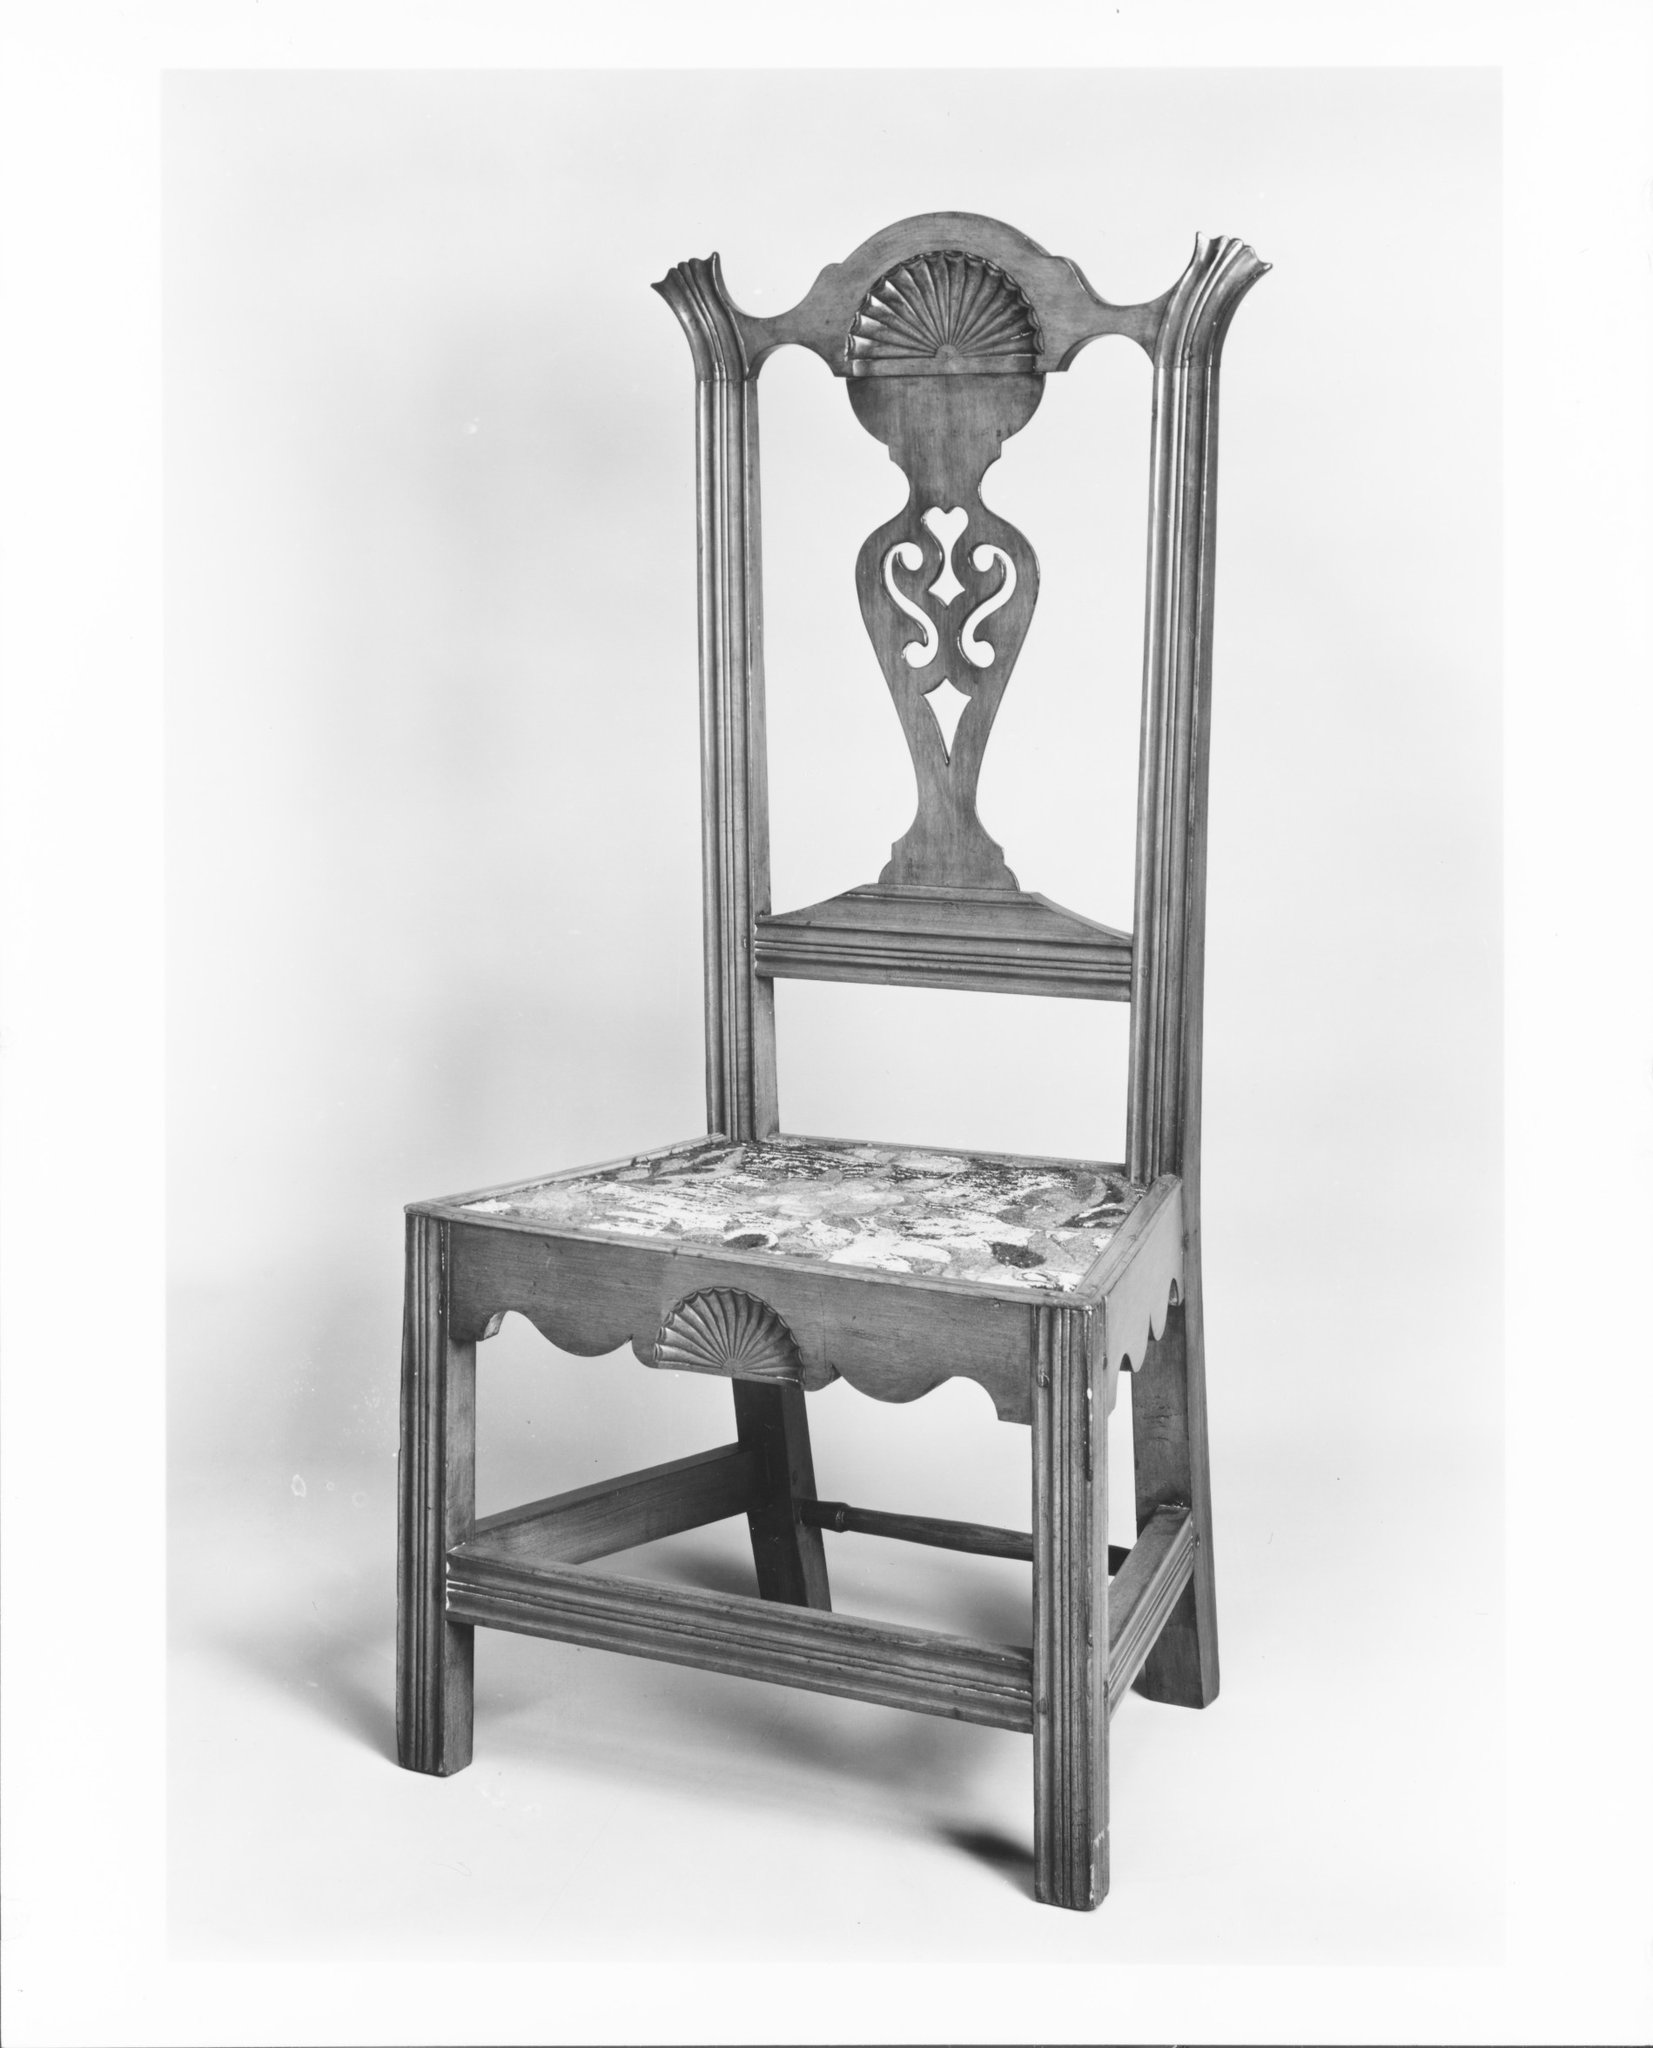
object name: side chair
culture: american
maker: major john dunlap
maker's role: maker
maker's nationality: american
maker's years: 1746-1792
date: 1770-1790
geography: united states